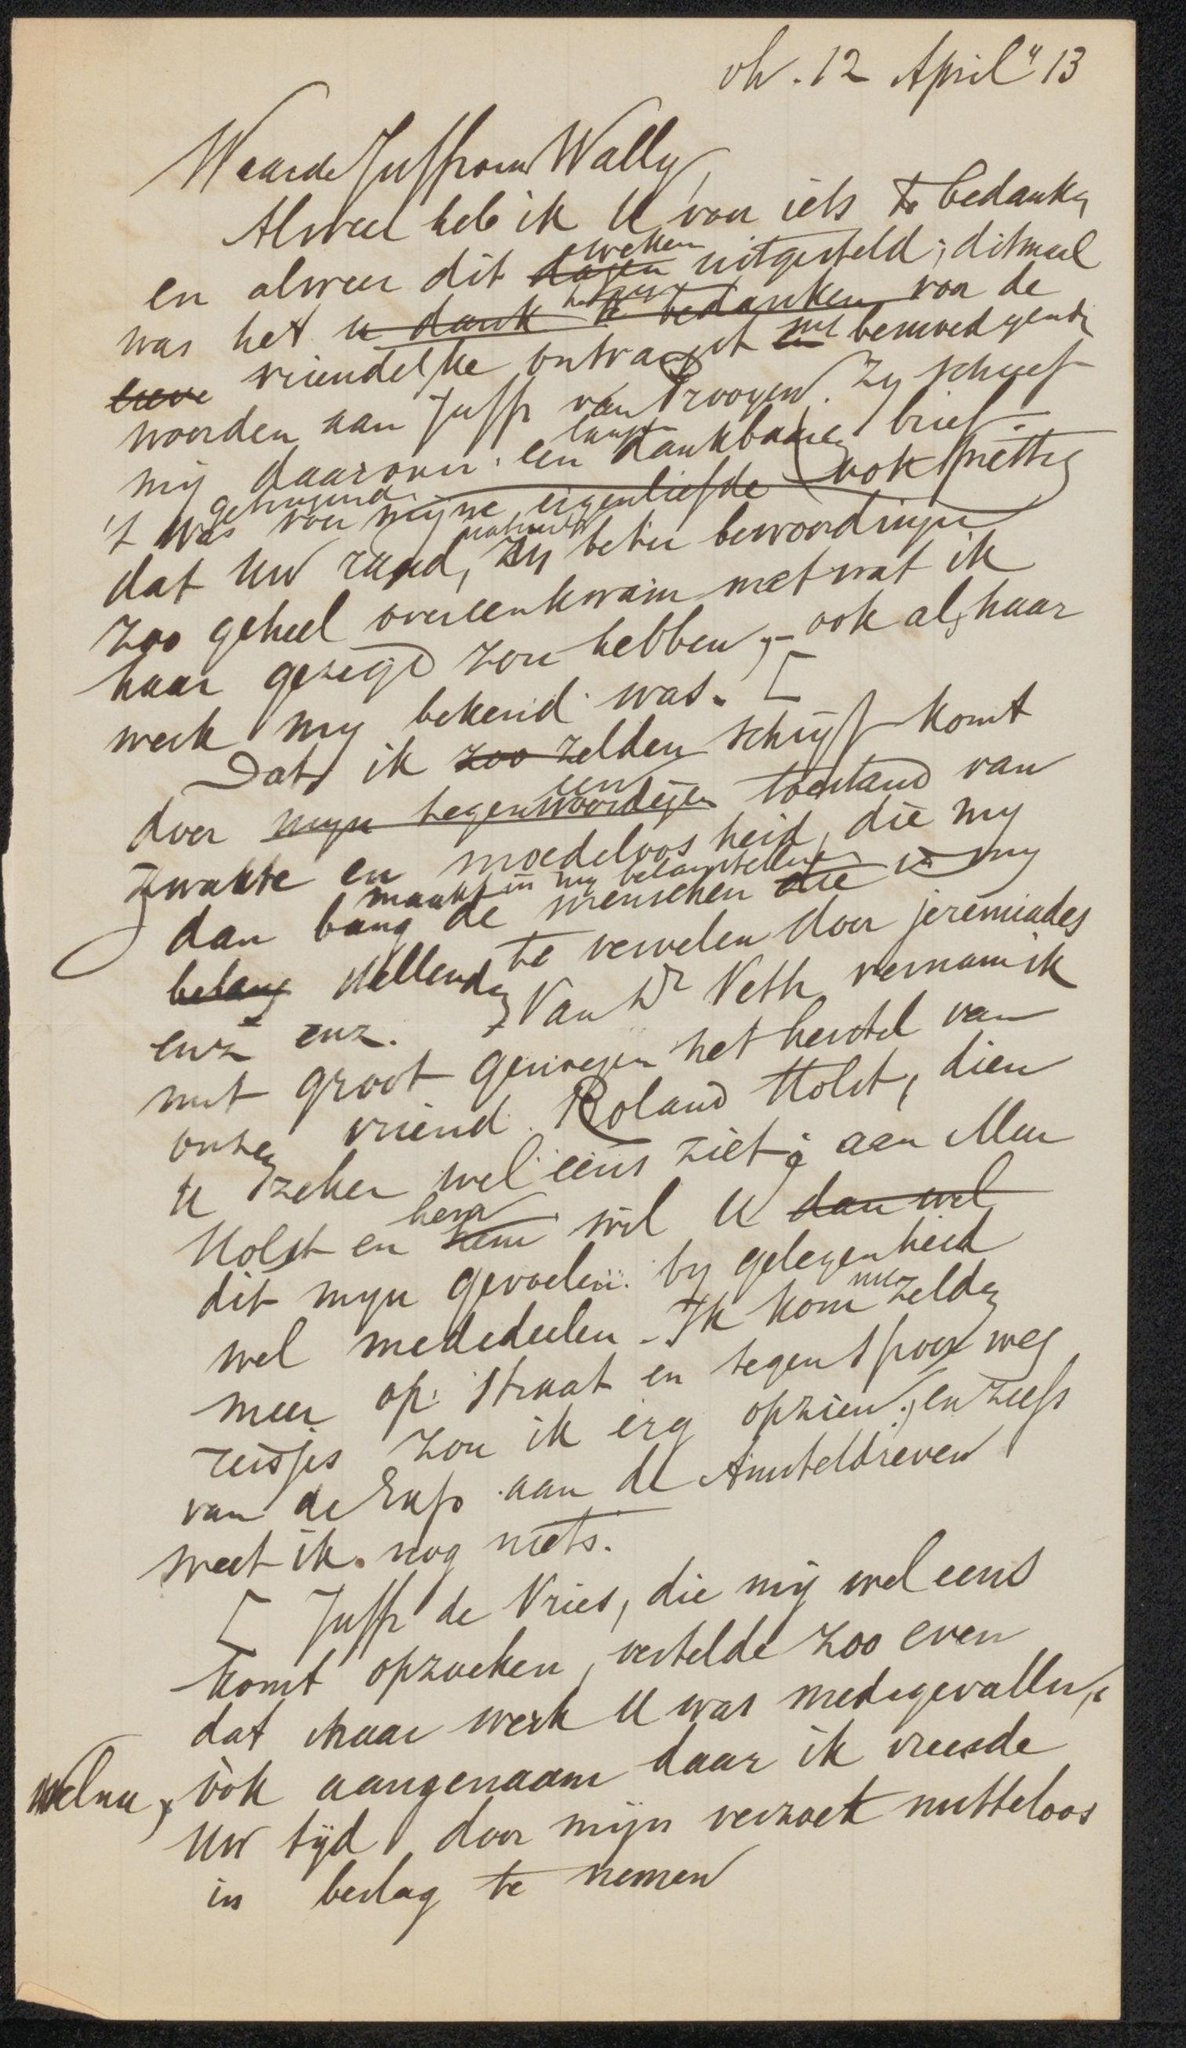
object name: letter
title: Conceptbrief aan Wally Moes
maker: august allebé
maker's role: draughtsman, print maker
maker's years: 1838-1927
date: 1913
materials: ink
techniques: pen, writing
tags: dordrecht, amsterdam, painter, print maker, draughtsman, designer, jan veth, wally moes, henriëtte de vries, richard nicolaüs roland holst, passions, emotions, affections